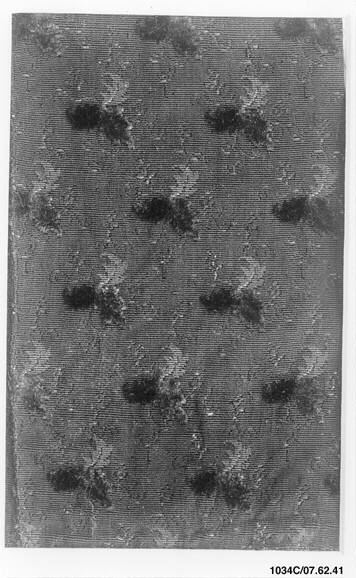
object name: fragment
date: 1801-1900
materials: silk